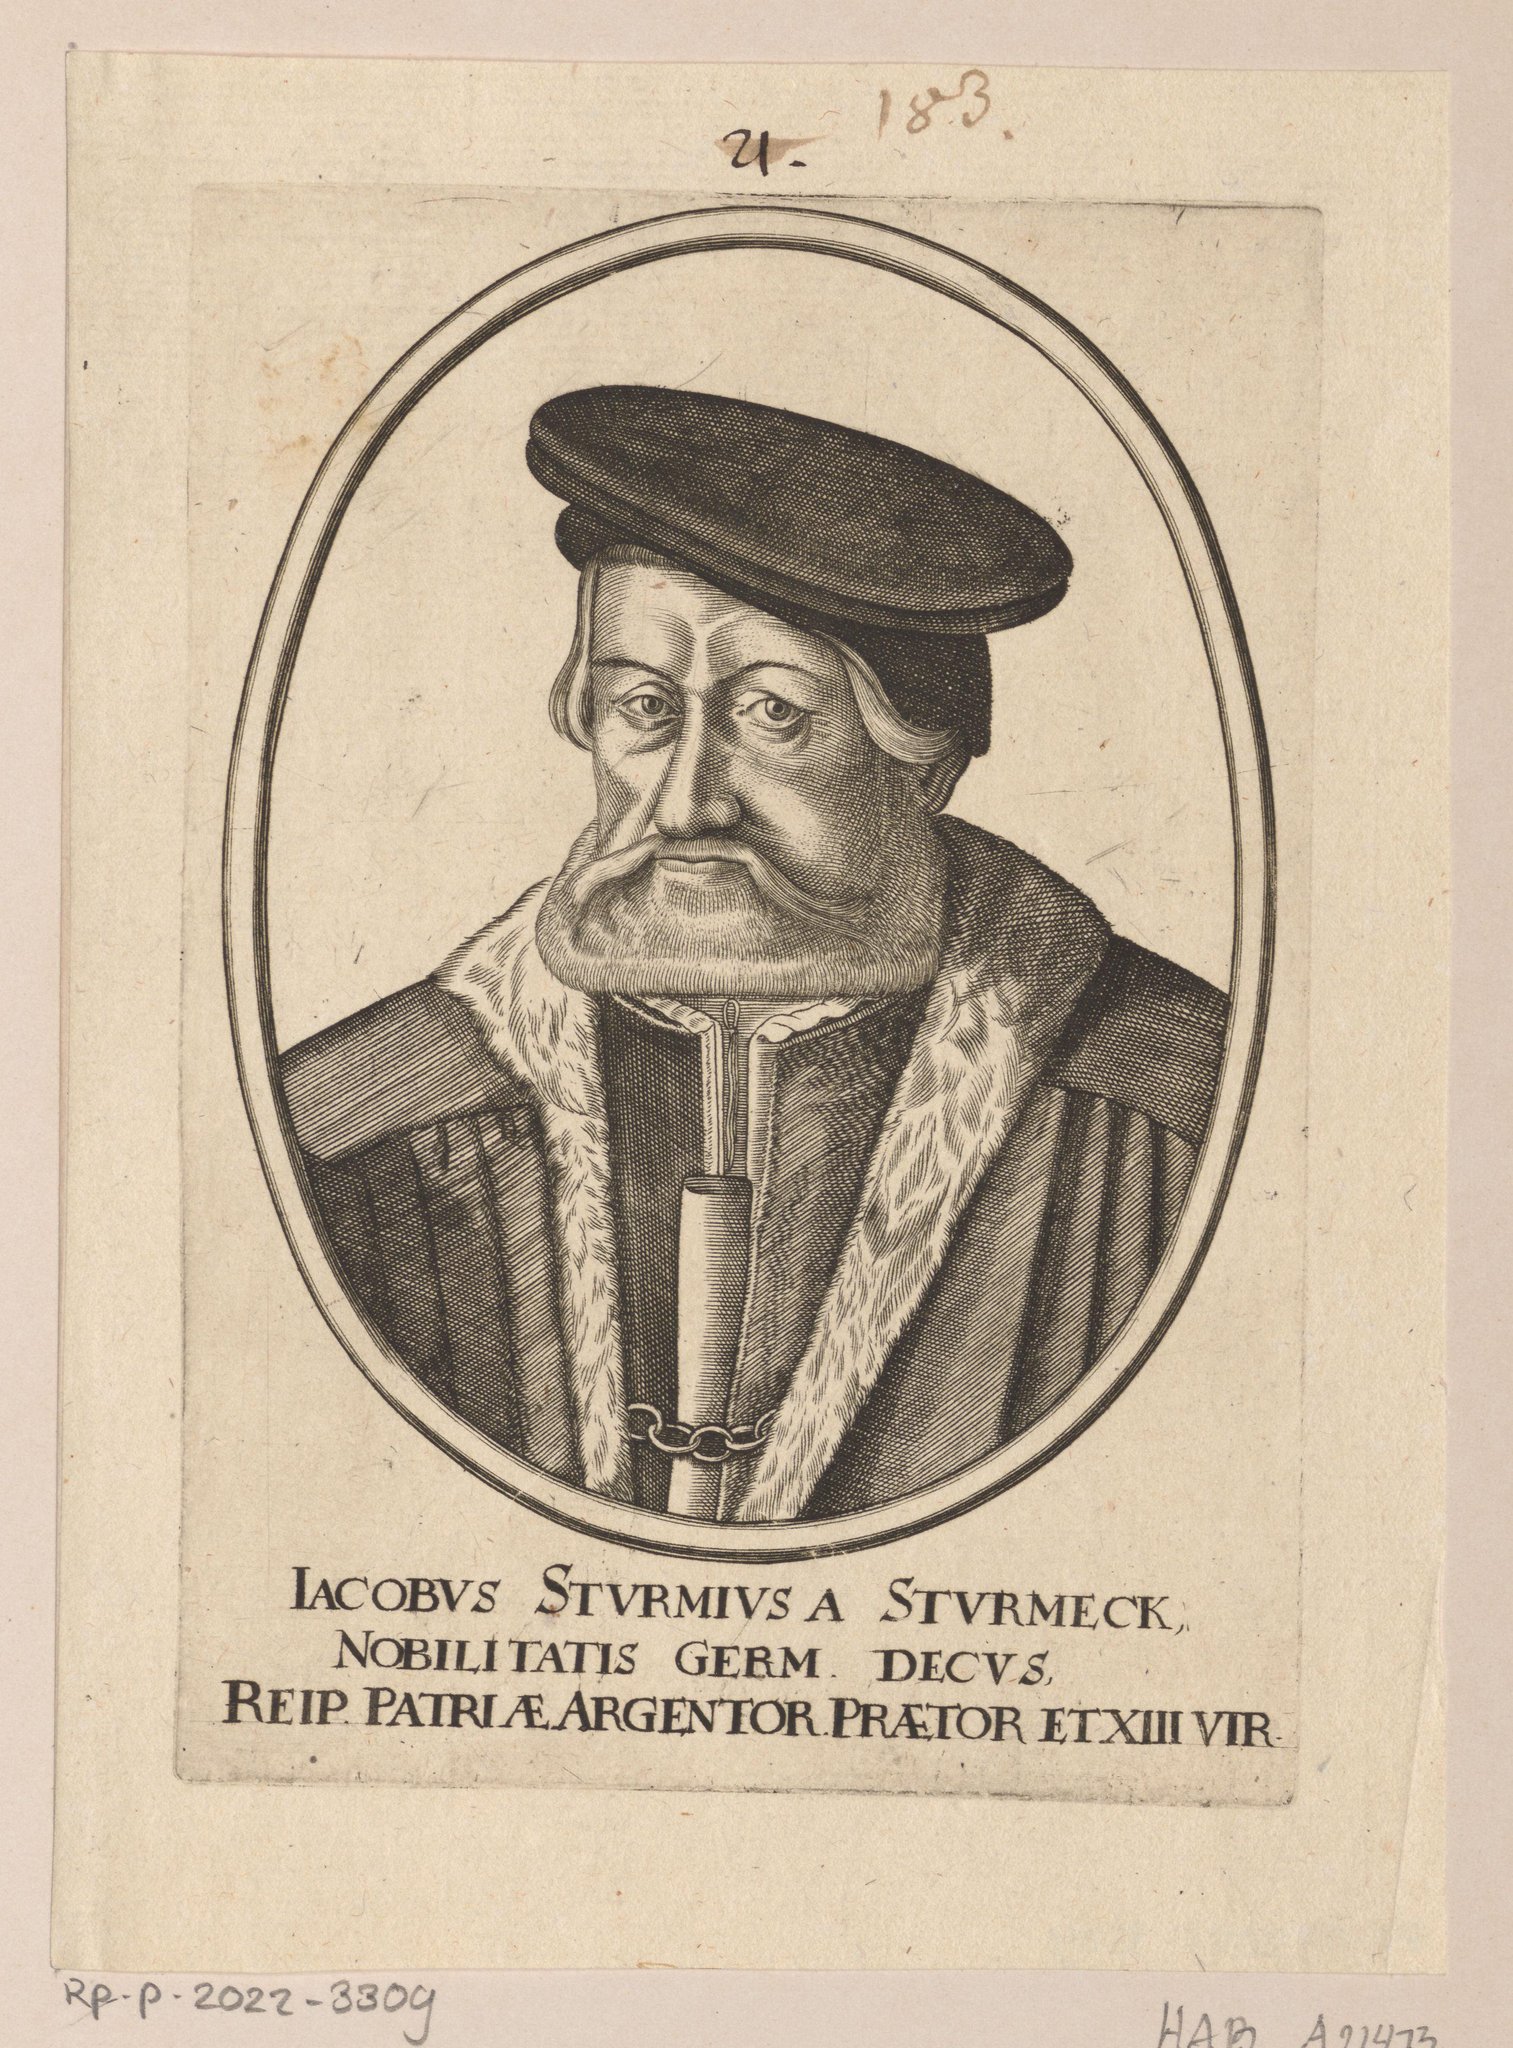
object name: print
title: Portret van Jakob Sturm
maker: peter aubry (ii)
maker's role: print maker, publisher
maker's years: 1596-1668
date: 1606-1668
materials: paper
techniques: engraving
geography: straatsburg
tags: official; civil servant; functionary (in general), historical persons, lawyer, attorney at law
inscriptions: number: ‘21’, number: ‘183’